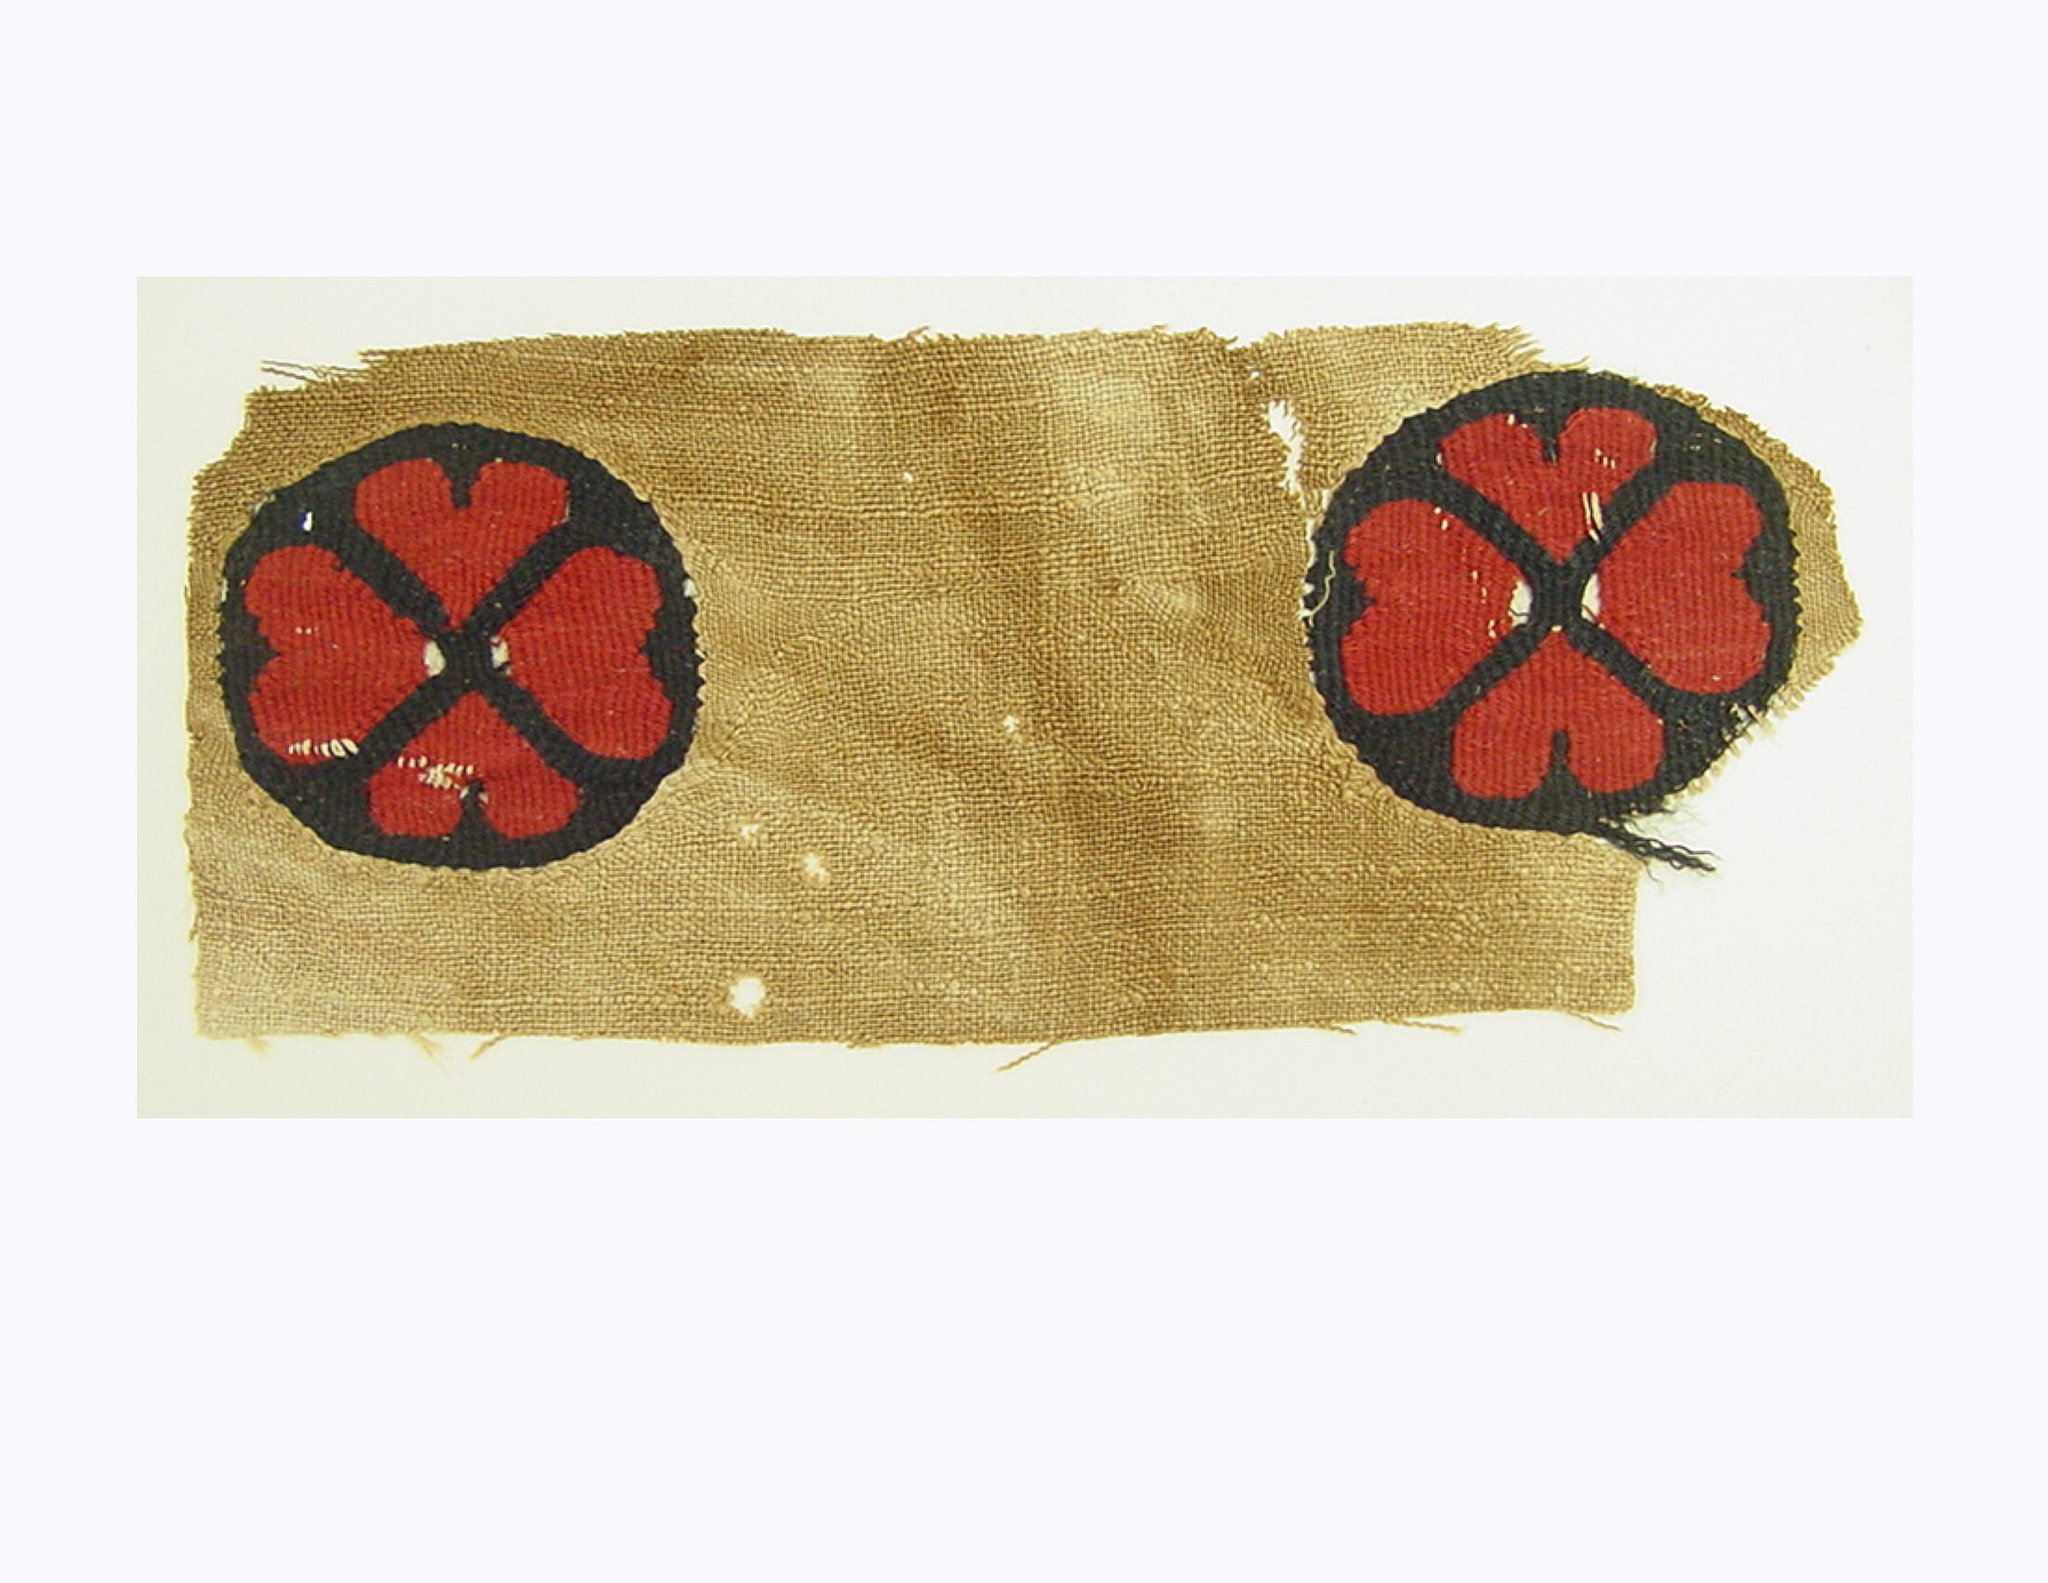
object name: textile fragment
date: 301-600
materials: linen, wool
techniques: weave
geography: egypt